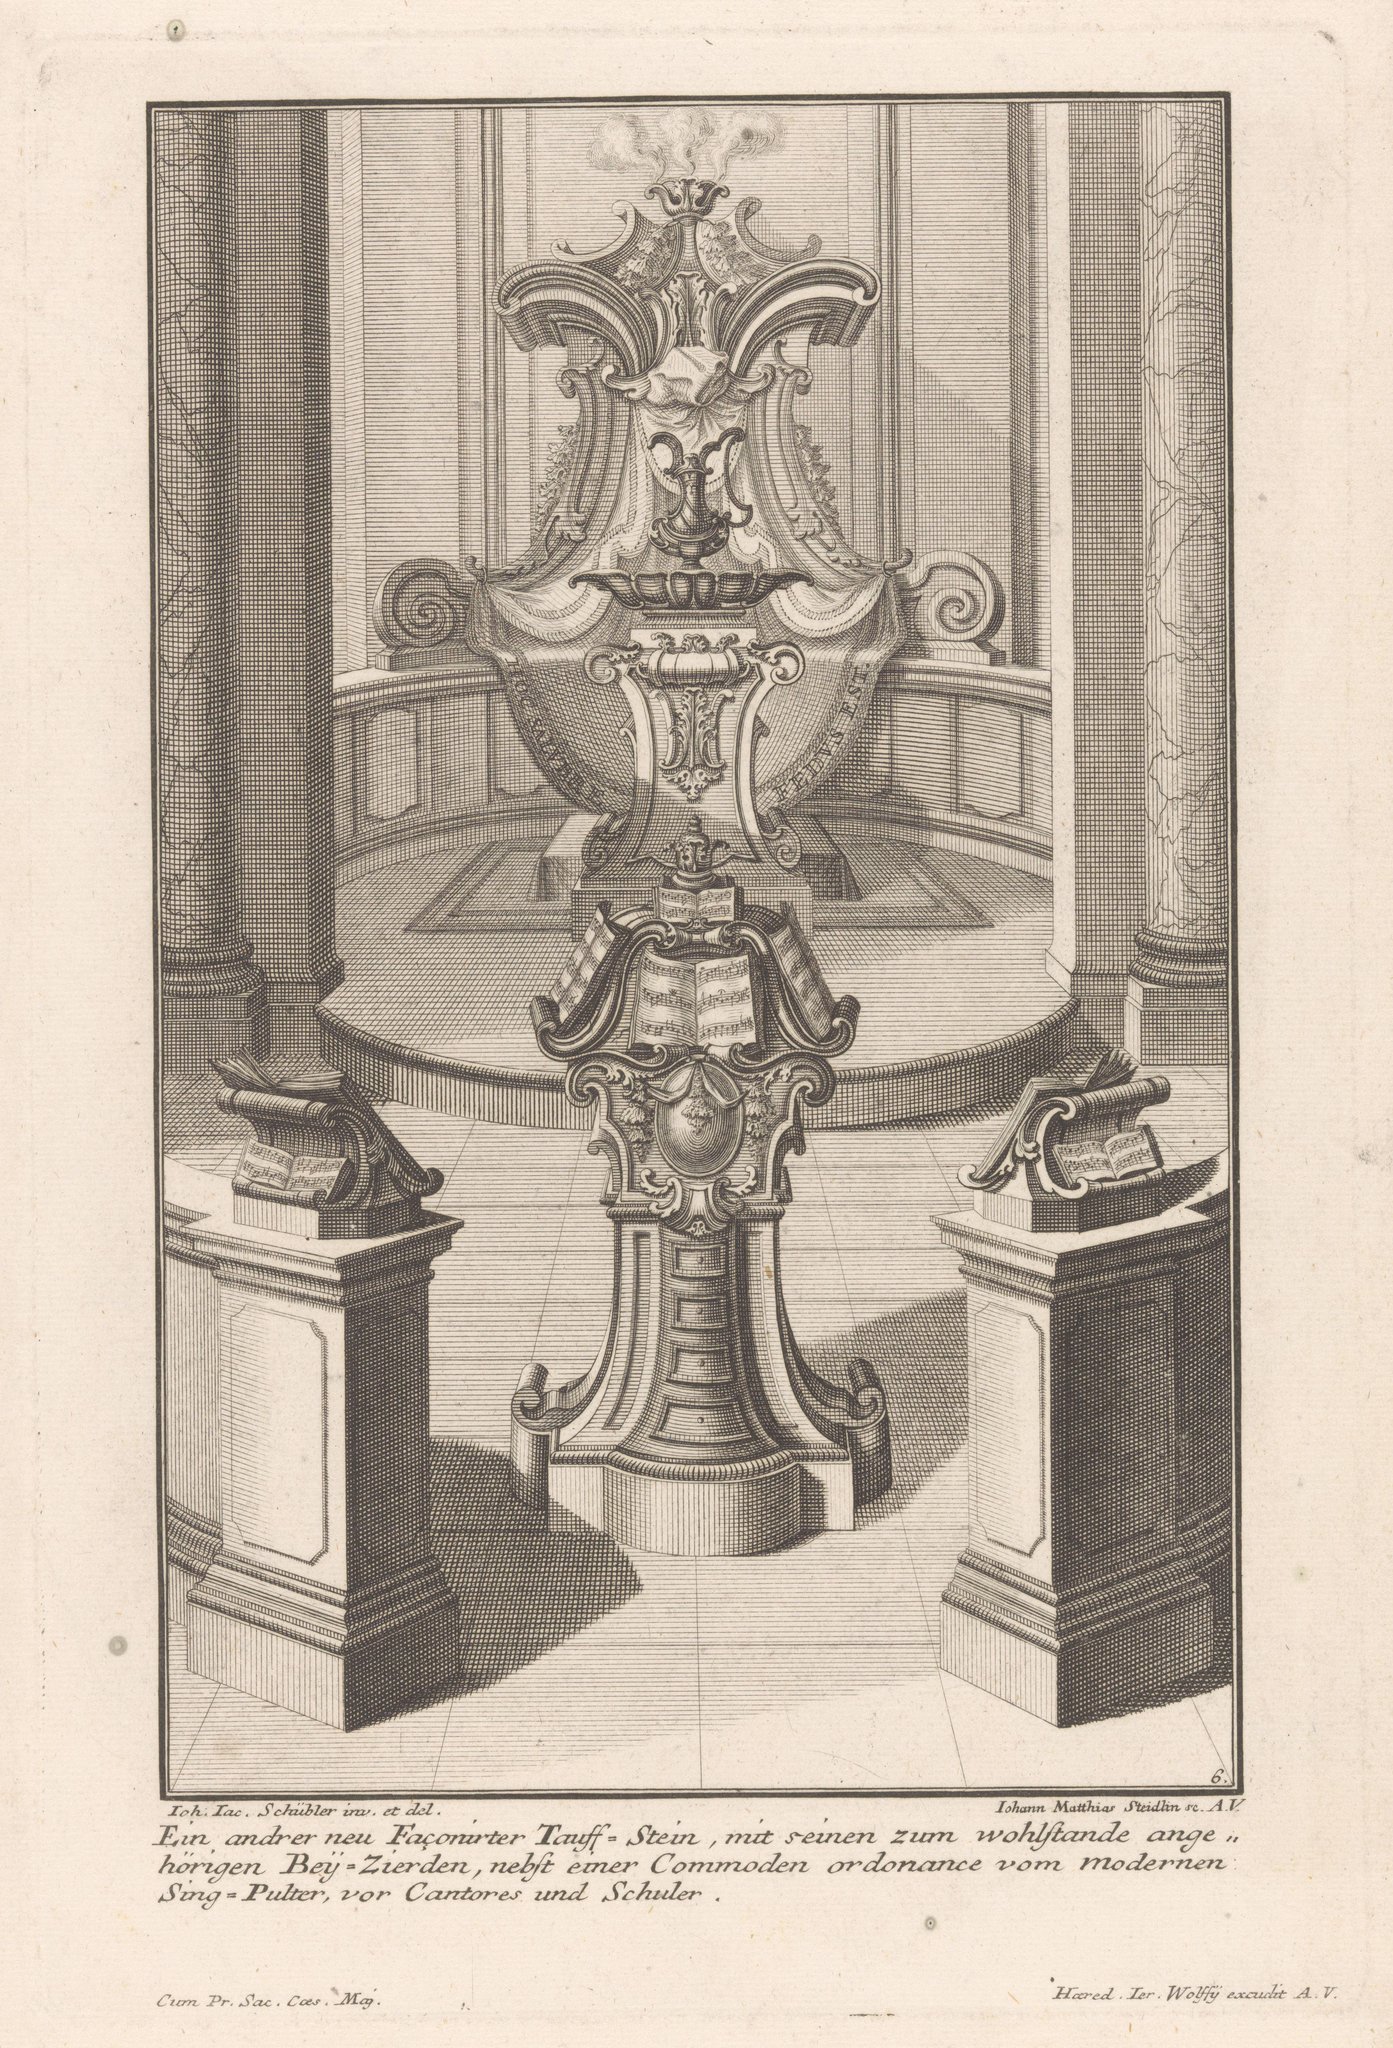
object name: ornament print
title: Doopvont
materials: paper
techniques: engraving, etching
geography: augsburg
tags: notation of music, lectern, baptismal font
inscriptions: collector's mark: Lugt 2760, collector's mark: Lugt 2228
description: Een geornamenteerd doopvont in een ronde kapel. Op de voorgrond lessenaars met bladmuziek. In de ondermarge een drieregelige Duitse tekst.